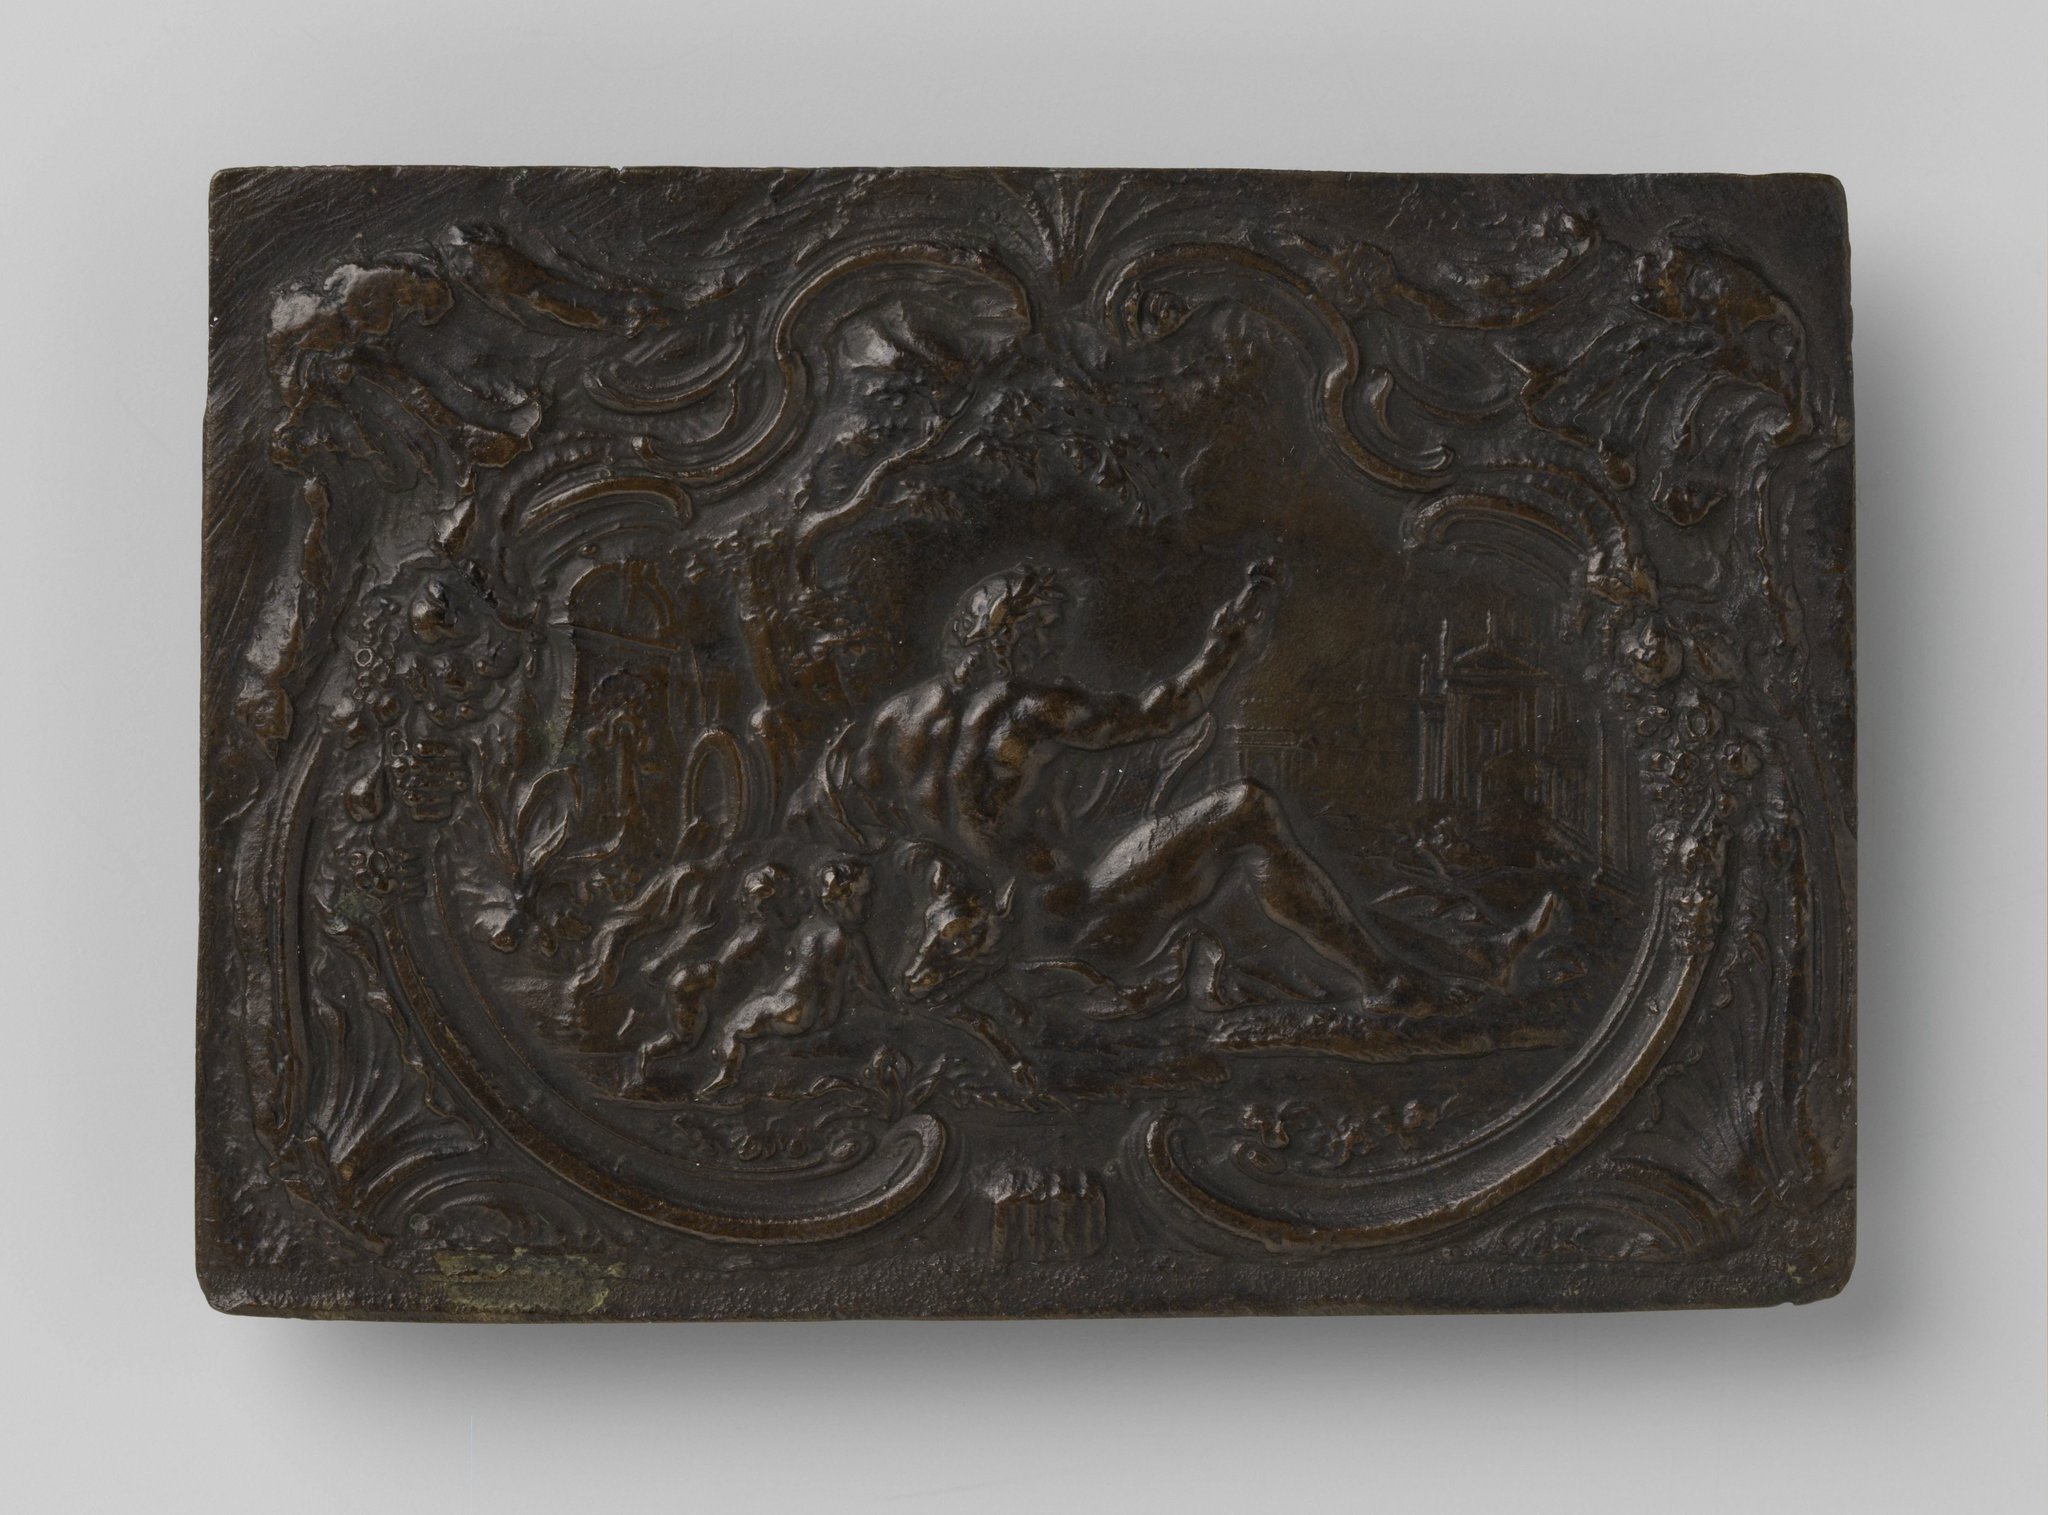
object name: plaque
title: Plaquette met de stroomgod Tiber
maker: Anonymous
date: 1750-1775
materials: bronze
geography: italy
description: Een plaquette van brons met een voorstelling van een stroomgod, de Tiber, met Romulus en Remus en de wolvin in een rocaille omlijsting.